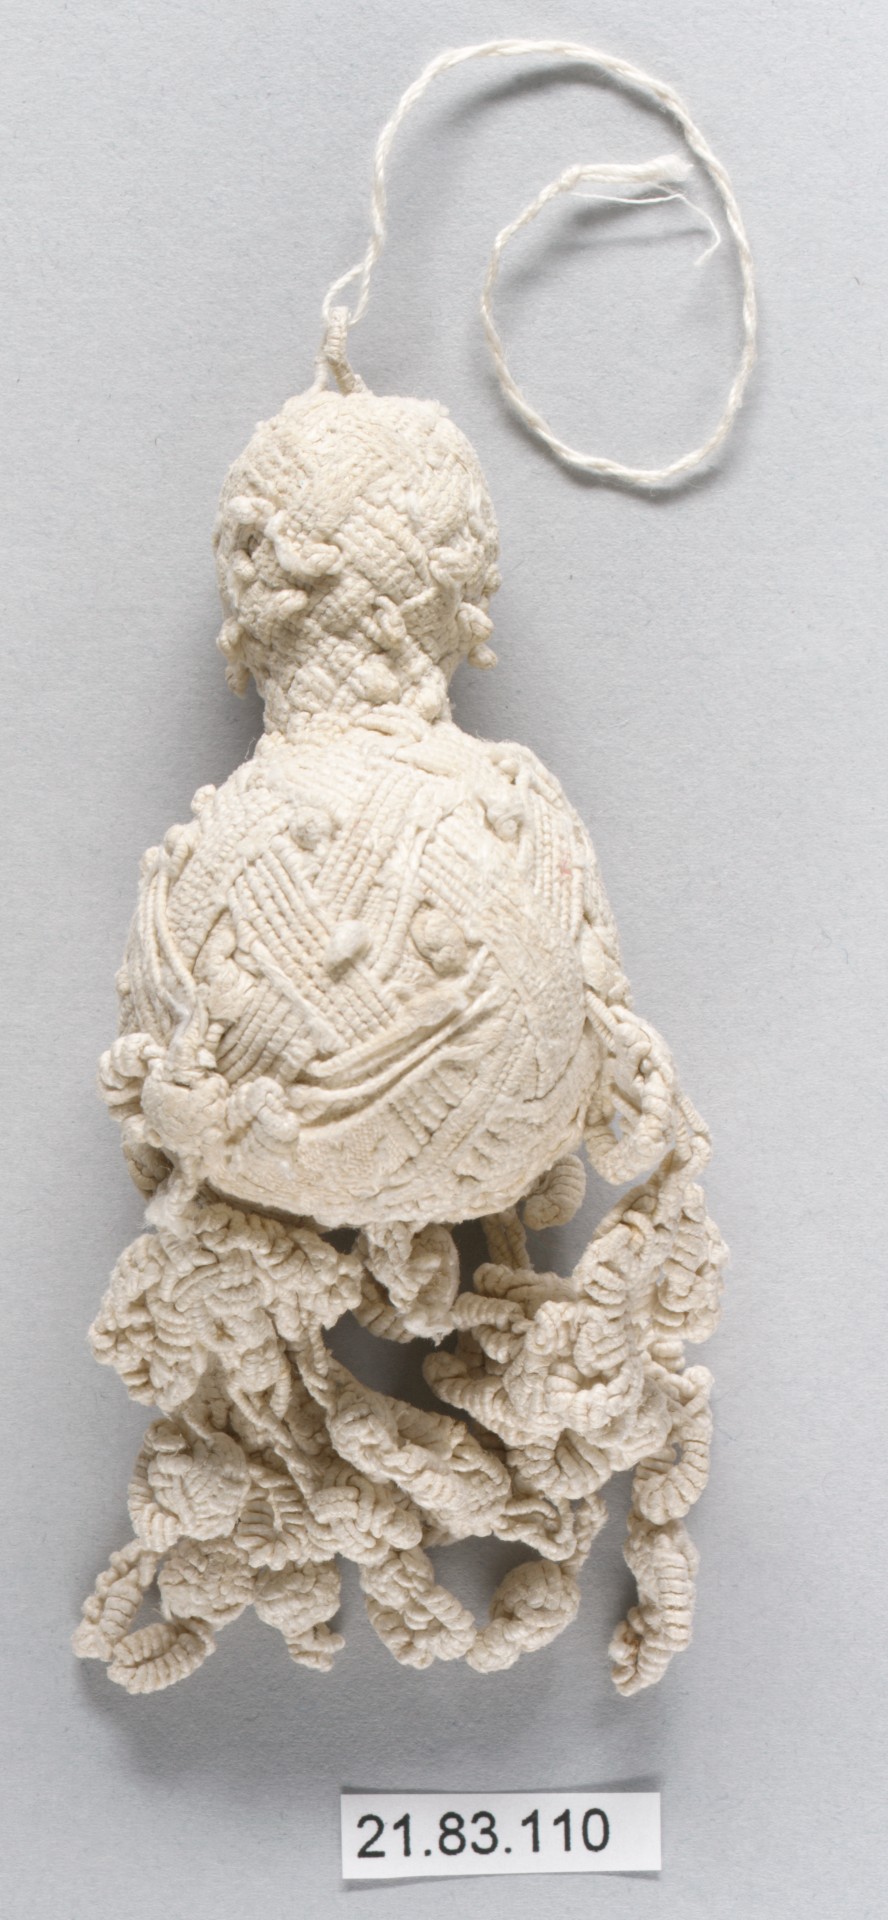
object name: tassel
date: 1601-1700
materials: linen